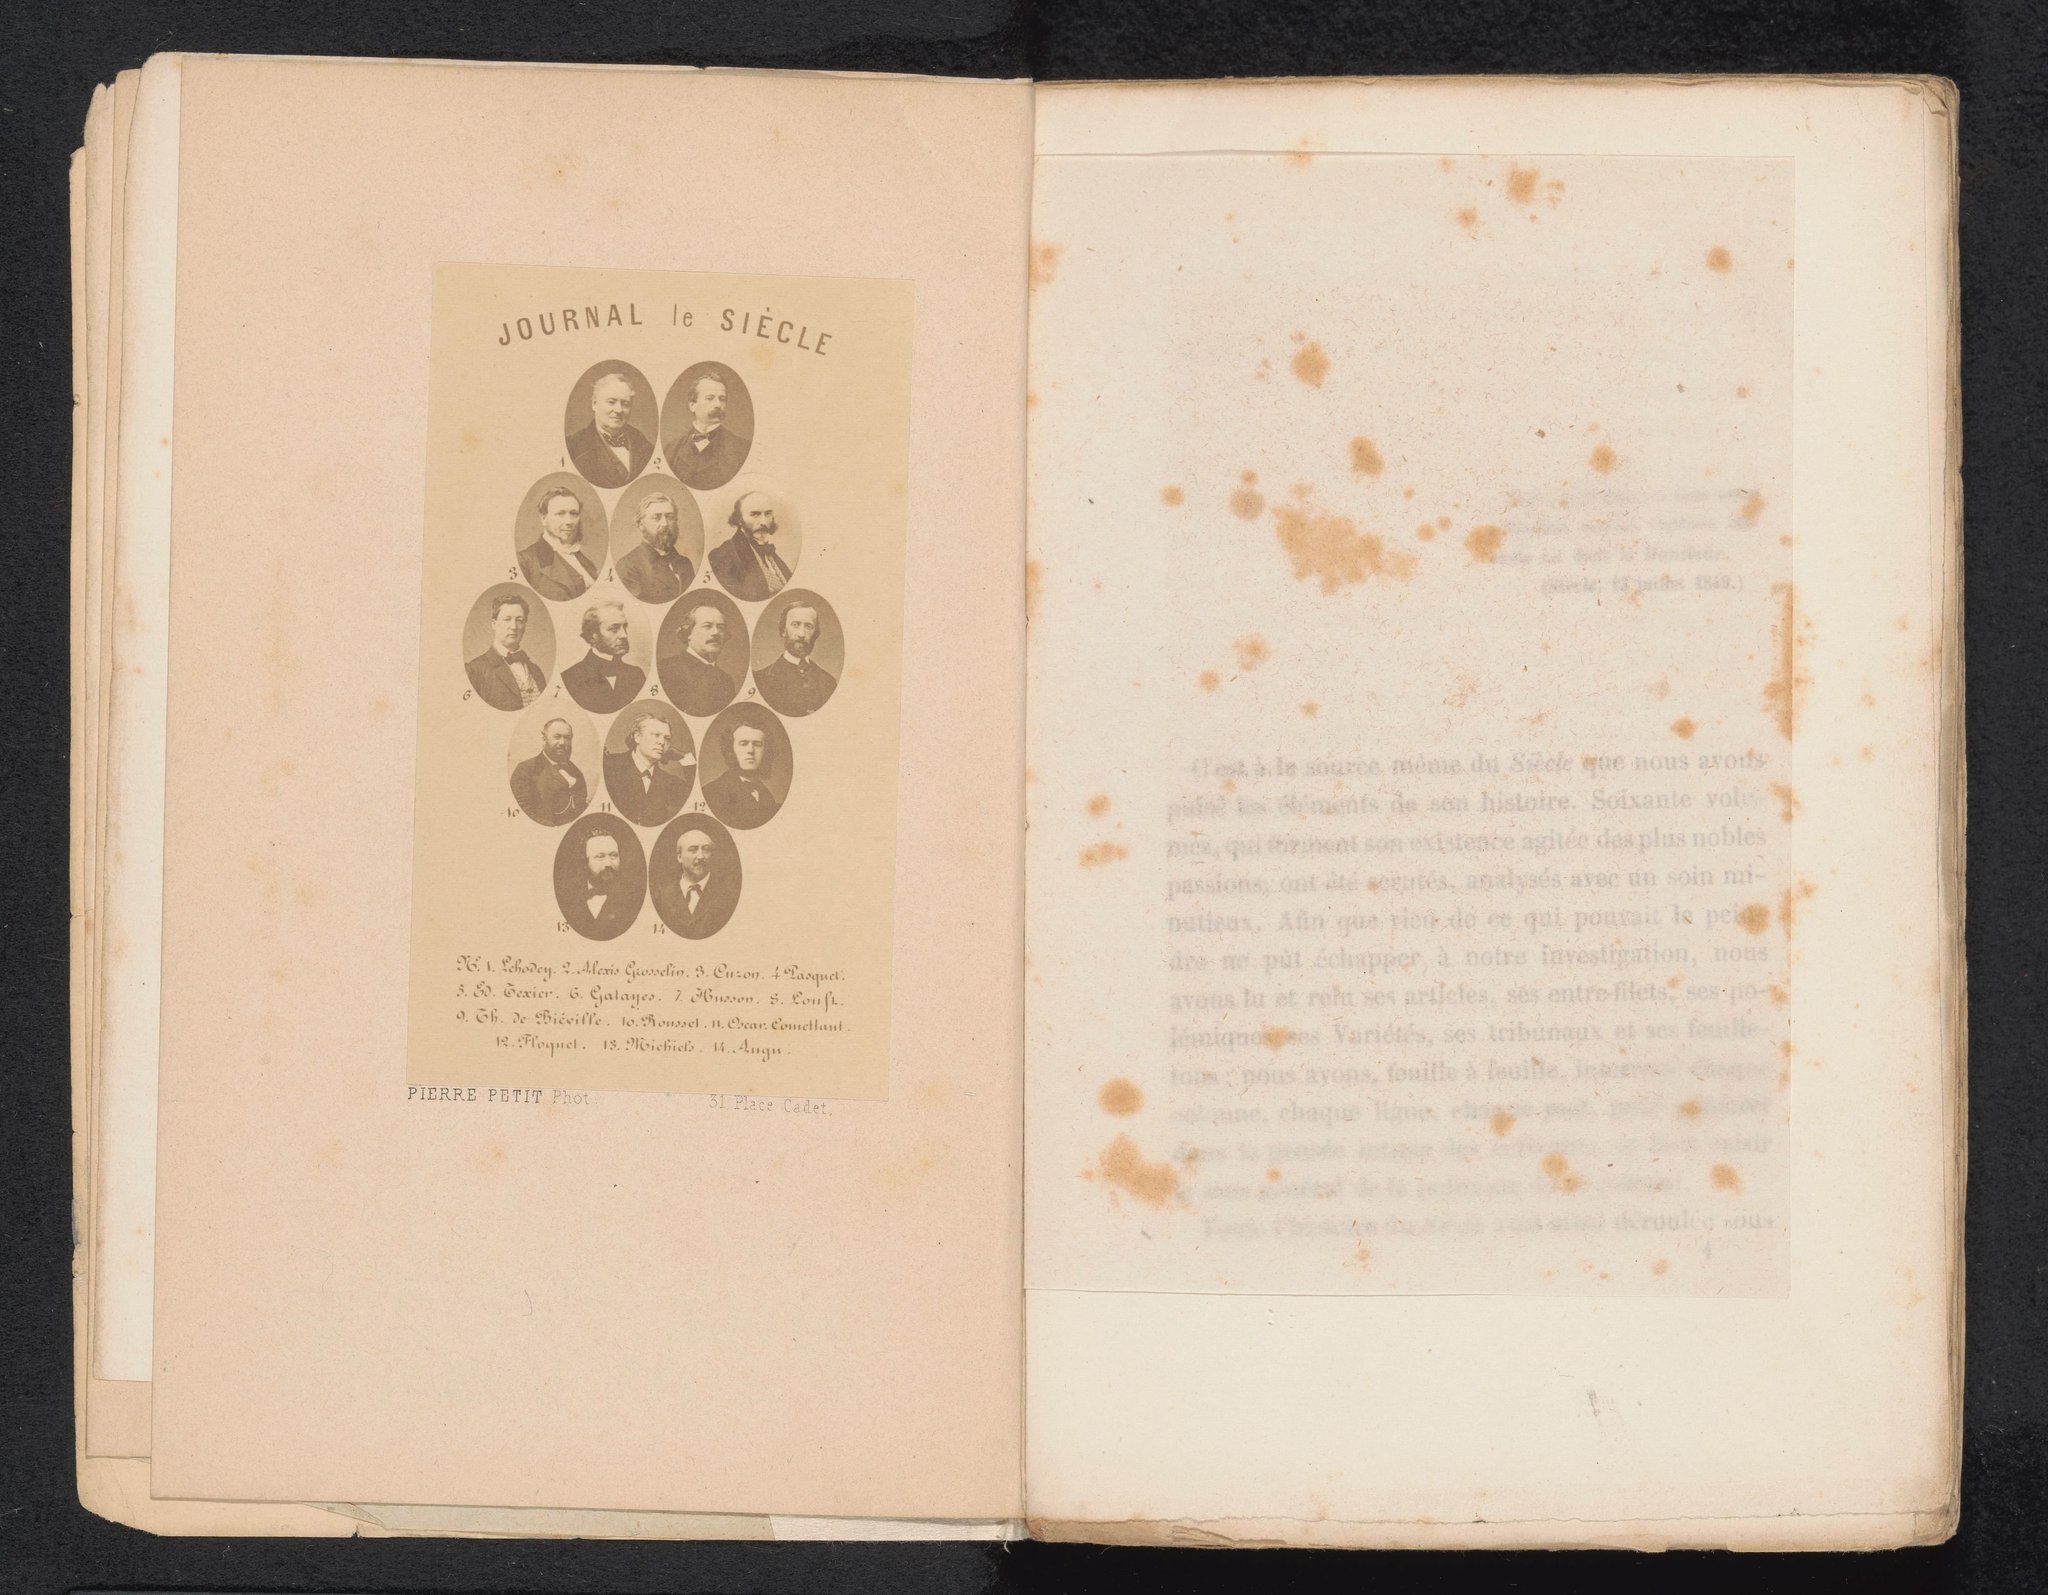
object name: page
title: Fotoreproductie van veertien portretten van nieuwsredacteurs van Le Siècle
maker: pierre petit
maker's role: fotograaf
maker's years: 1832-1909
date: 1861-1866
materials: photographic support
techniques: albumen print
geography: paris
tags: editorial board, pressmen, newspaper, news-sheet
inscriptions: number: ‘1 (...) 14’, name: ‘Pierre Petit phot. 31, Place Cadet’, inscription: ‘Lehadey (...) Augu.’